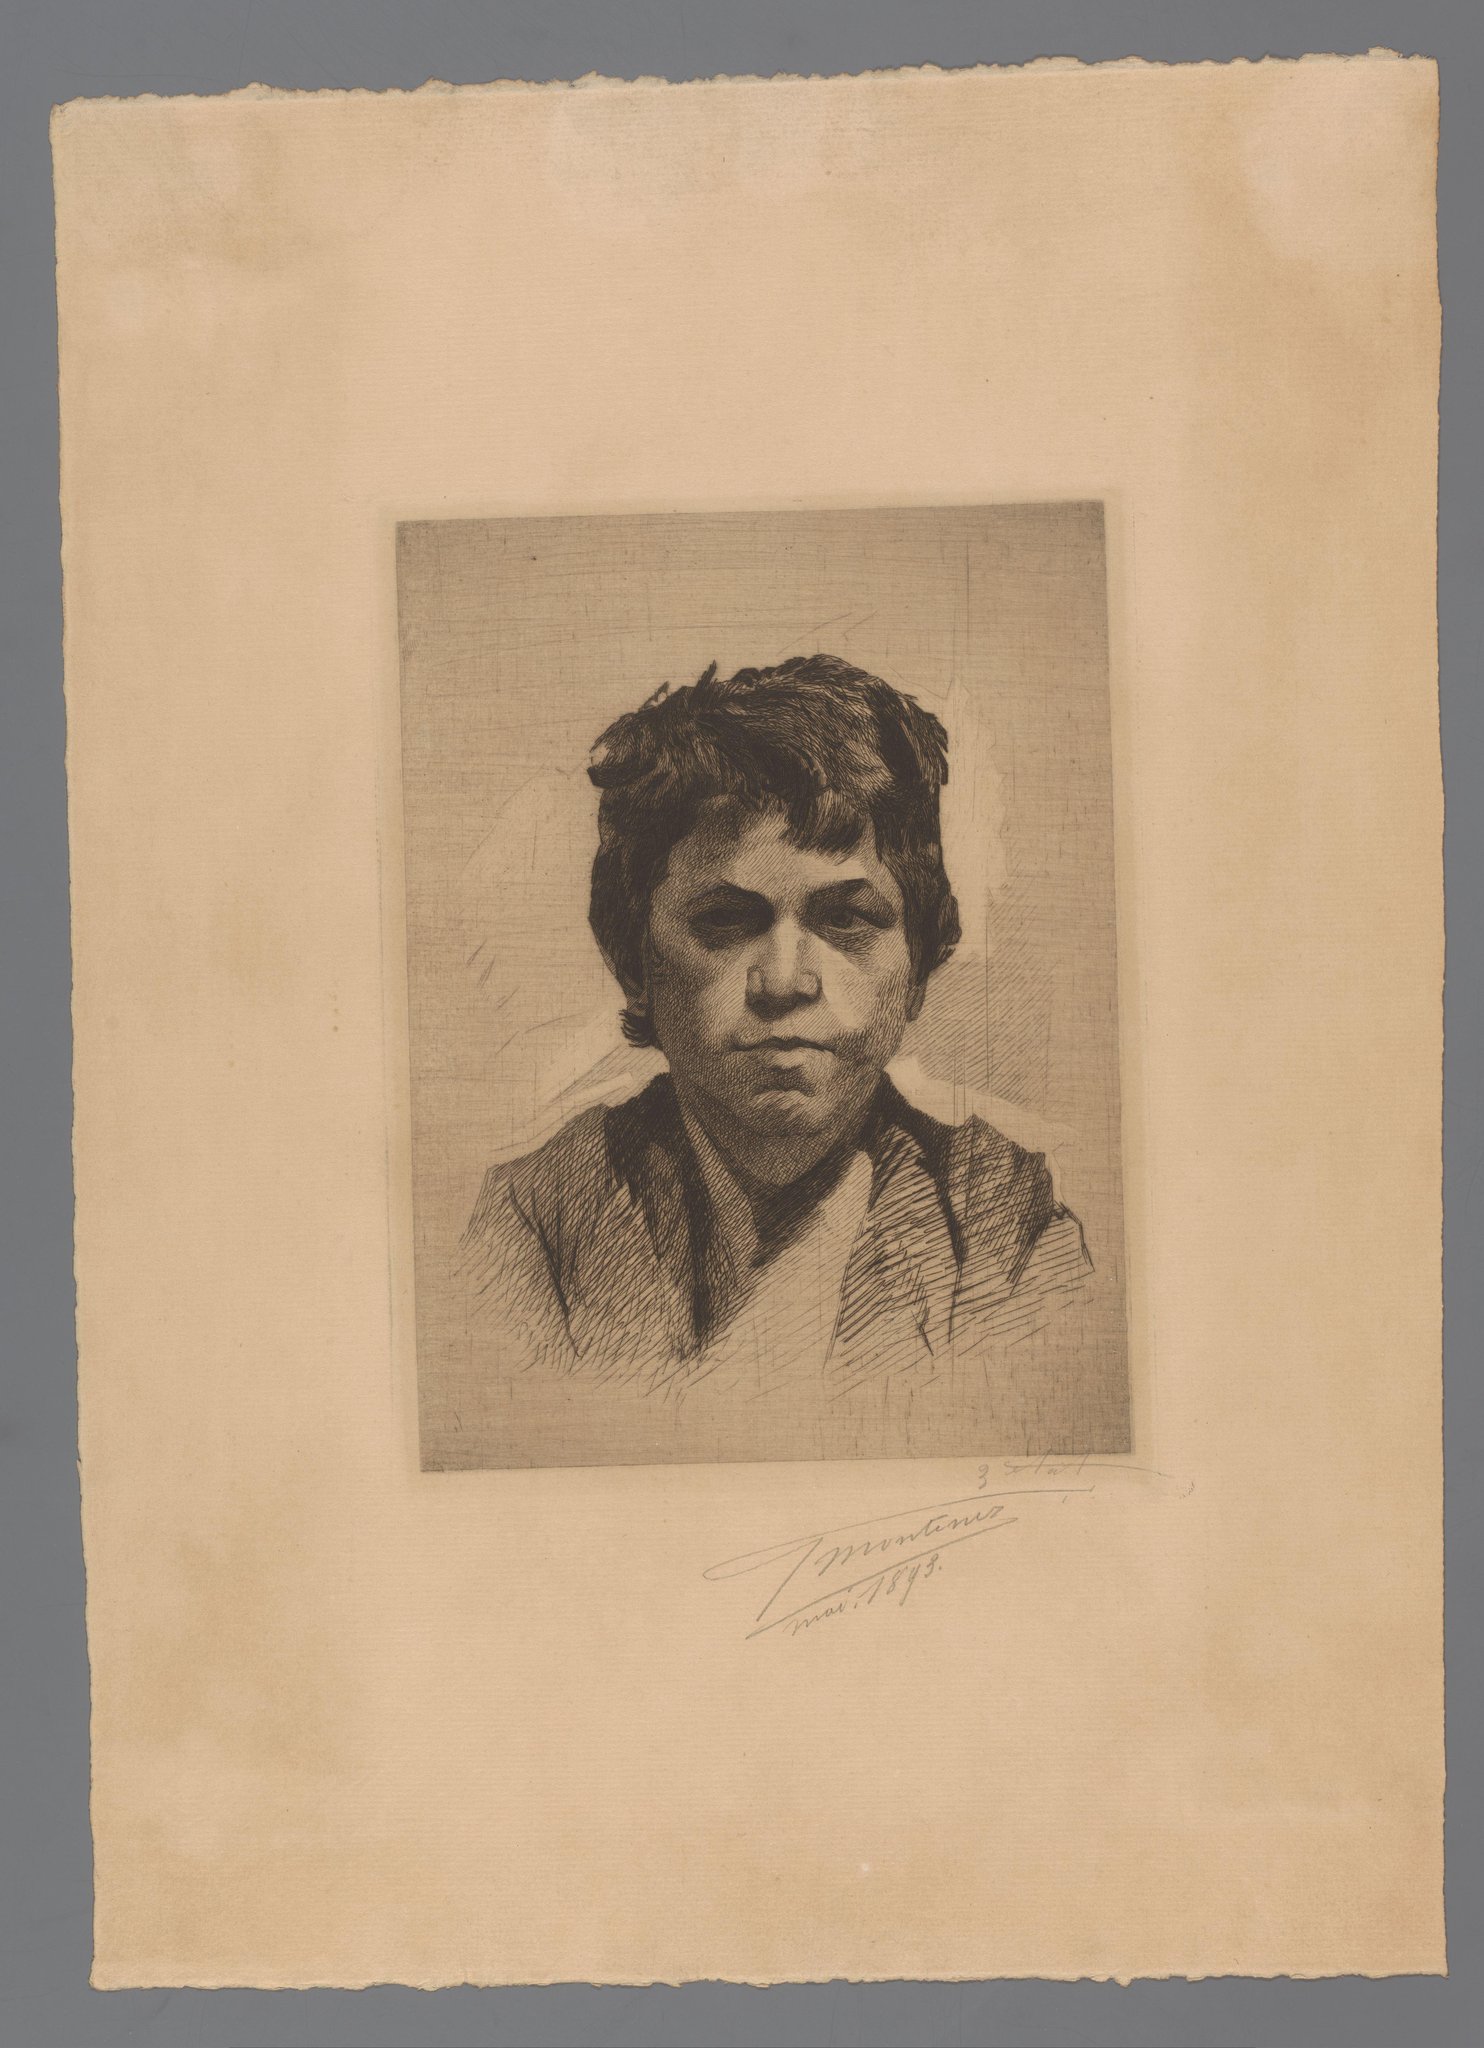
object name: print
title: Portret van een onbekende jongen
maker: georges montenez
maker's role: print maker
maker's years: 1873-1930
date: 1893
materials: paper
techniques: etching, intaglio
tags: historical persons, youth, adolescent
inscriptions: collector's mark: Lugt 2228, inscription: ‘3 etat; mai 1893’